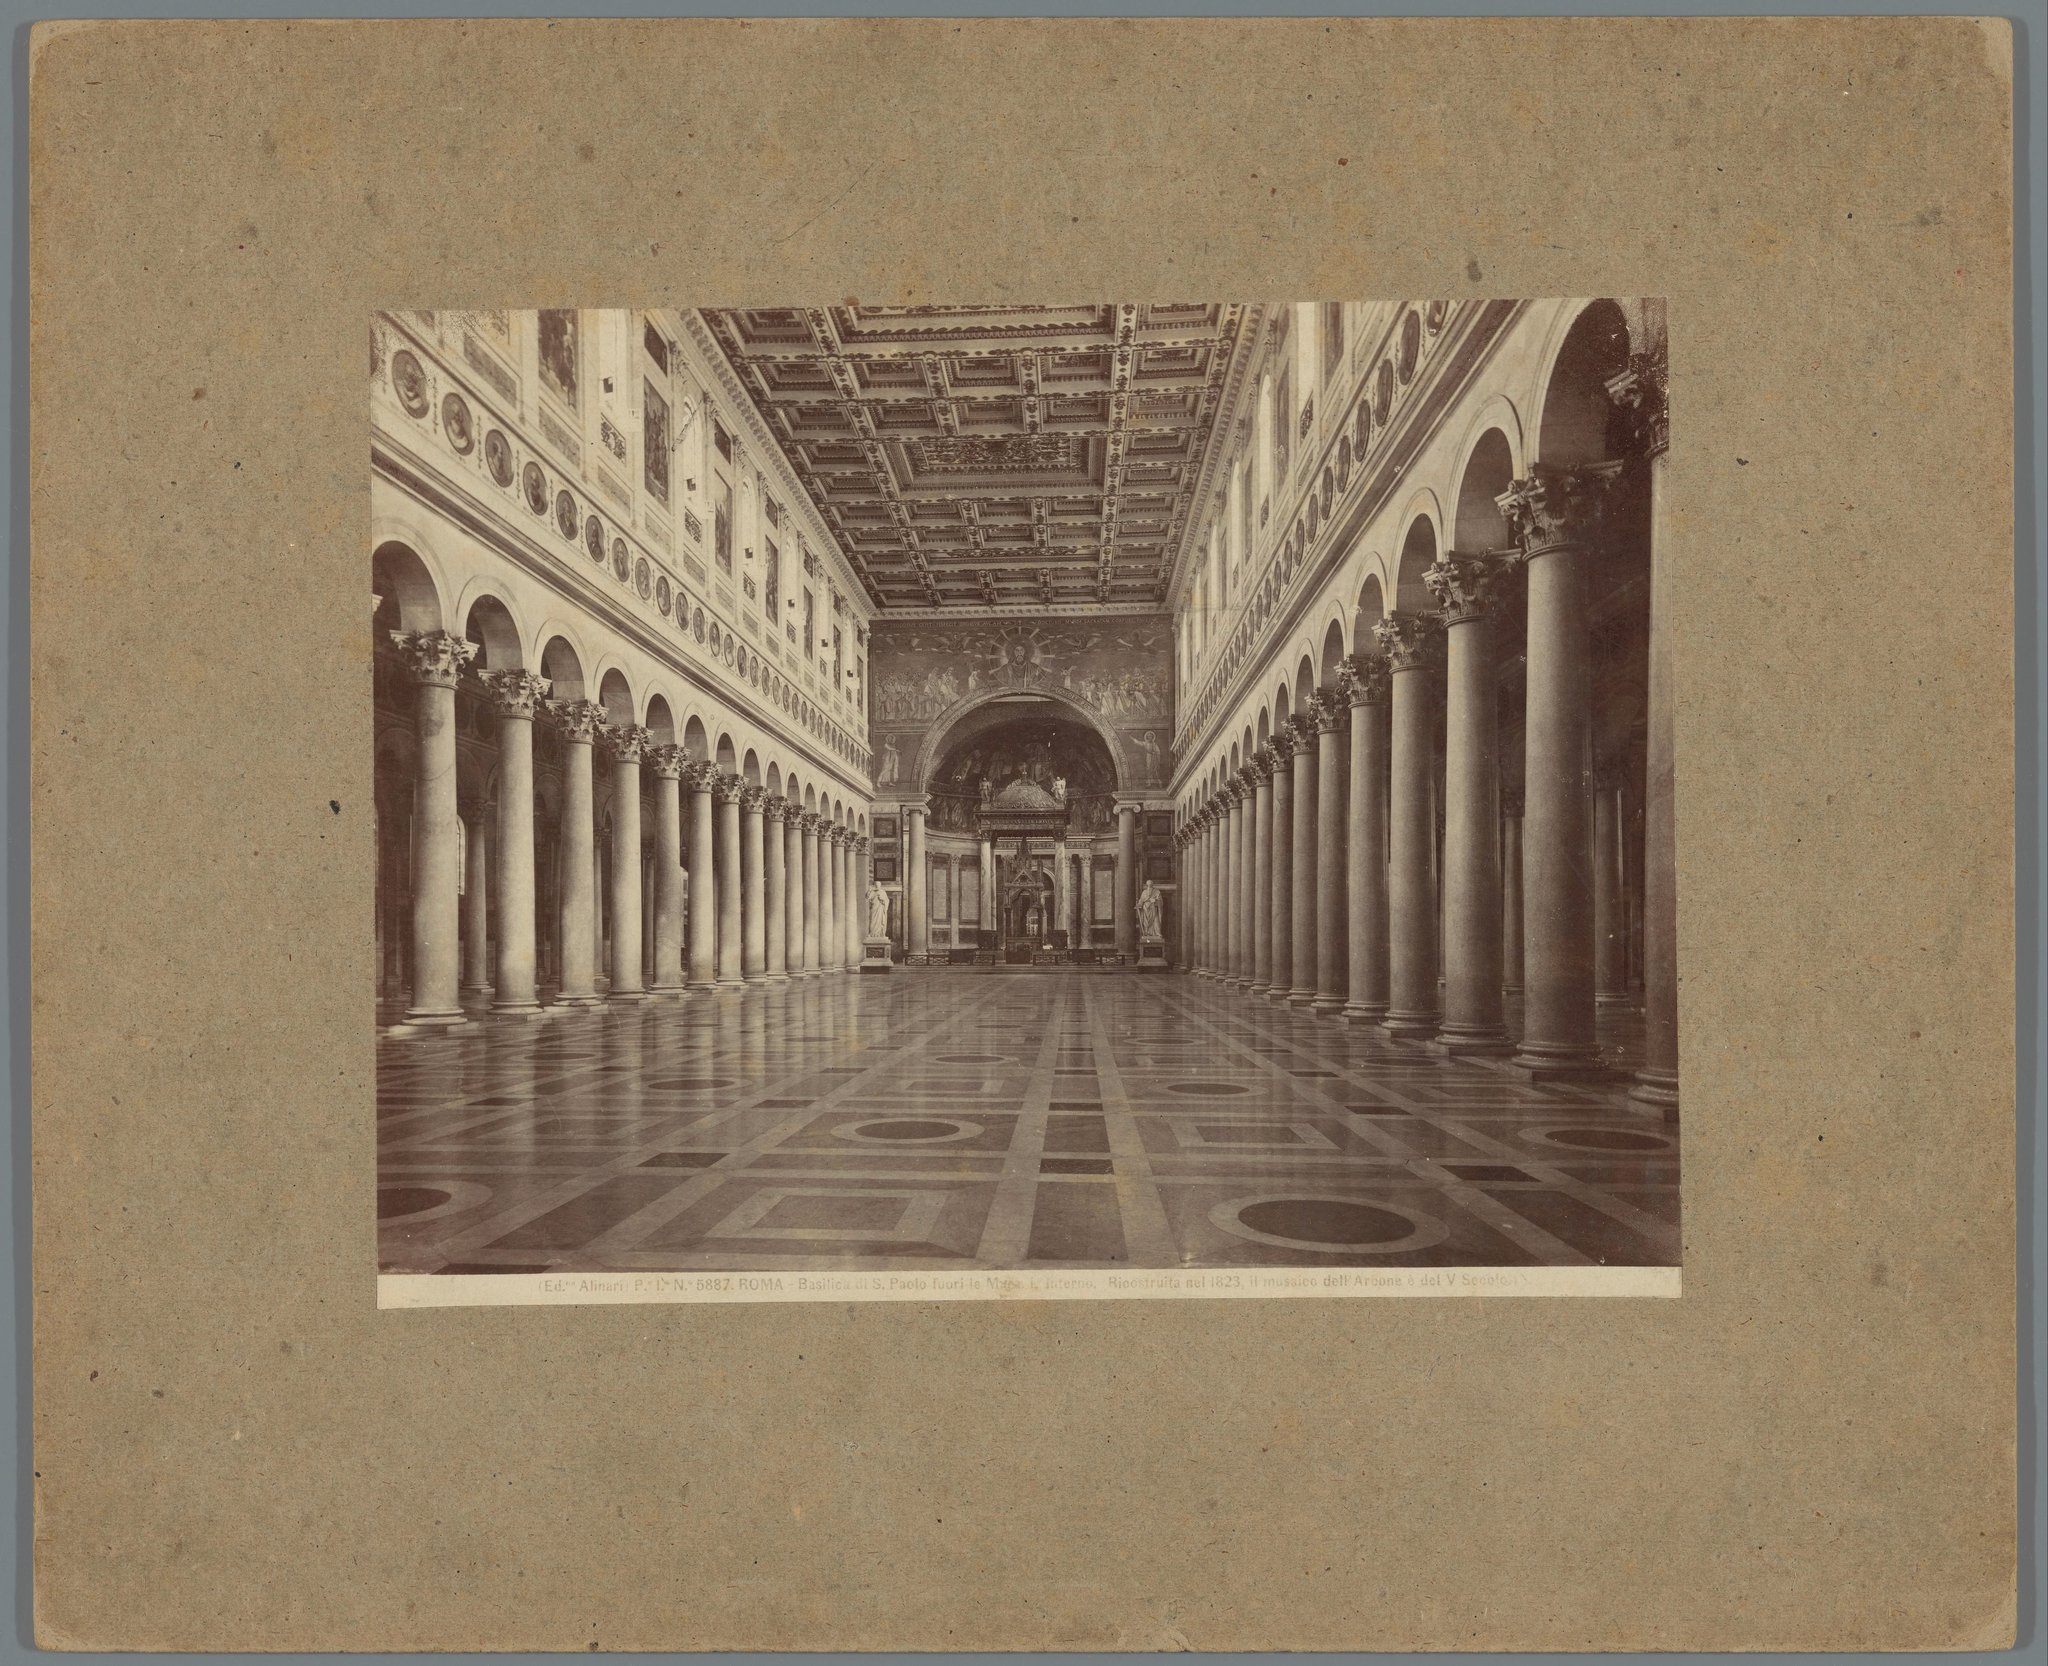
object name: photograph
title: ROMA - Basilica di S. Paolo fuori le Mura. Interno.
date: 1875-1900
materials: cardboard, photographic support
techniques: albumen print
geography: sint-paulus buiten de muren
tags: interior of church, parts of church interior: choir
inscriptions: inscription: ‘O.C. 61.’, collector's mark: Lugt 3937, number: ‘P.e I.a N.o 5887.’